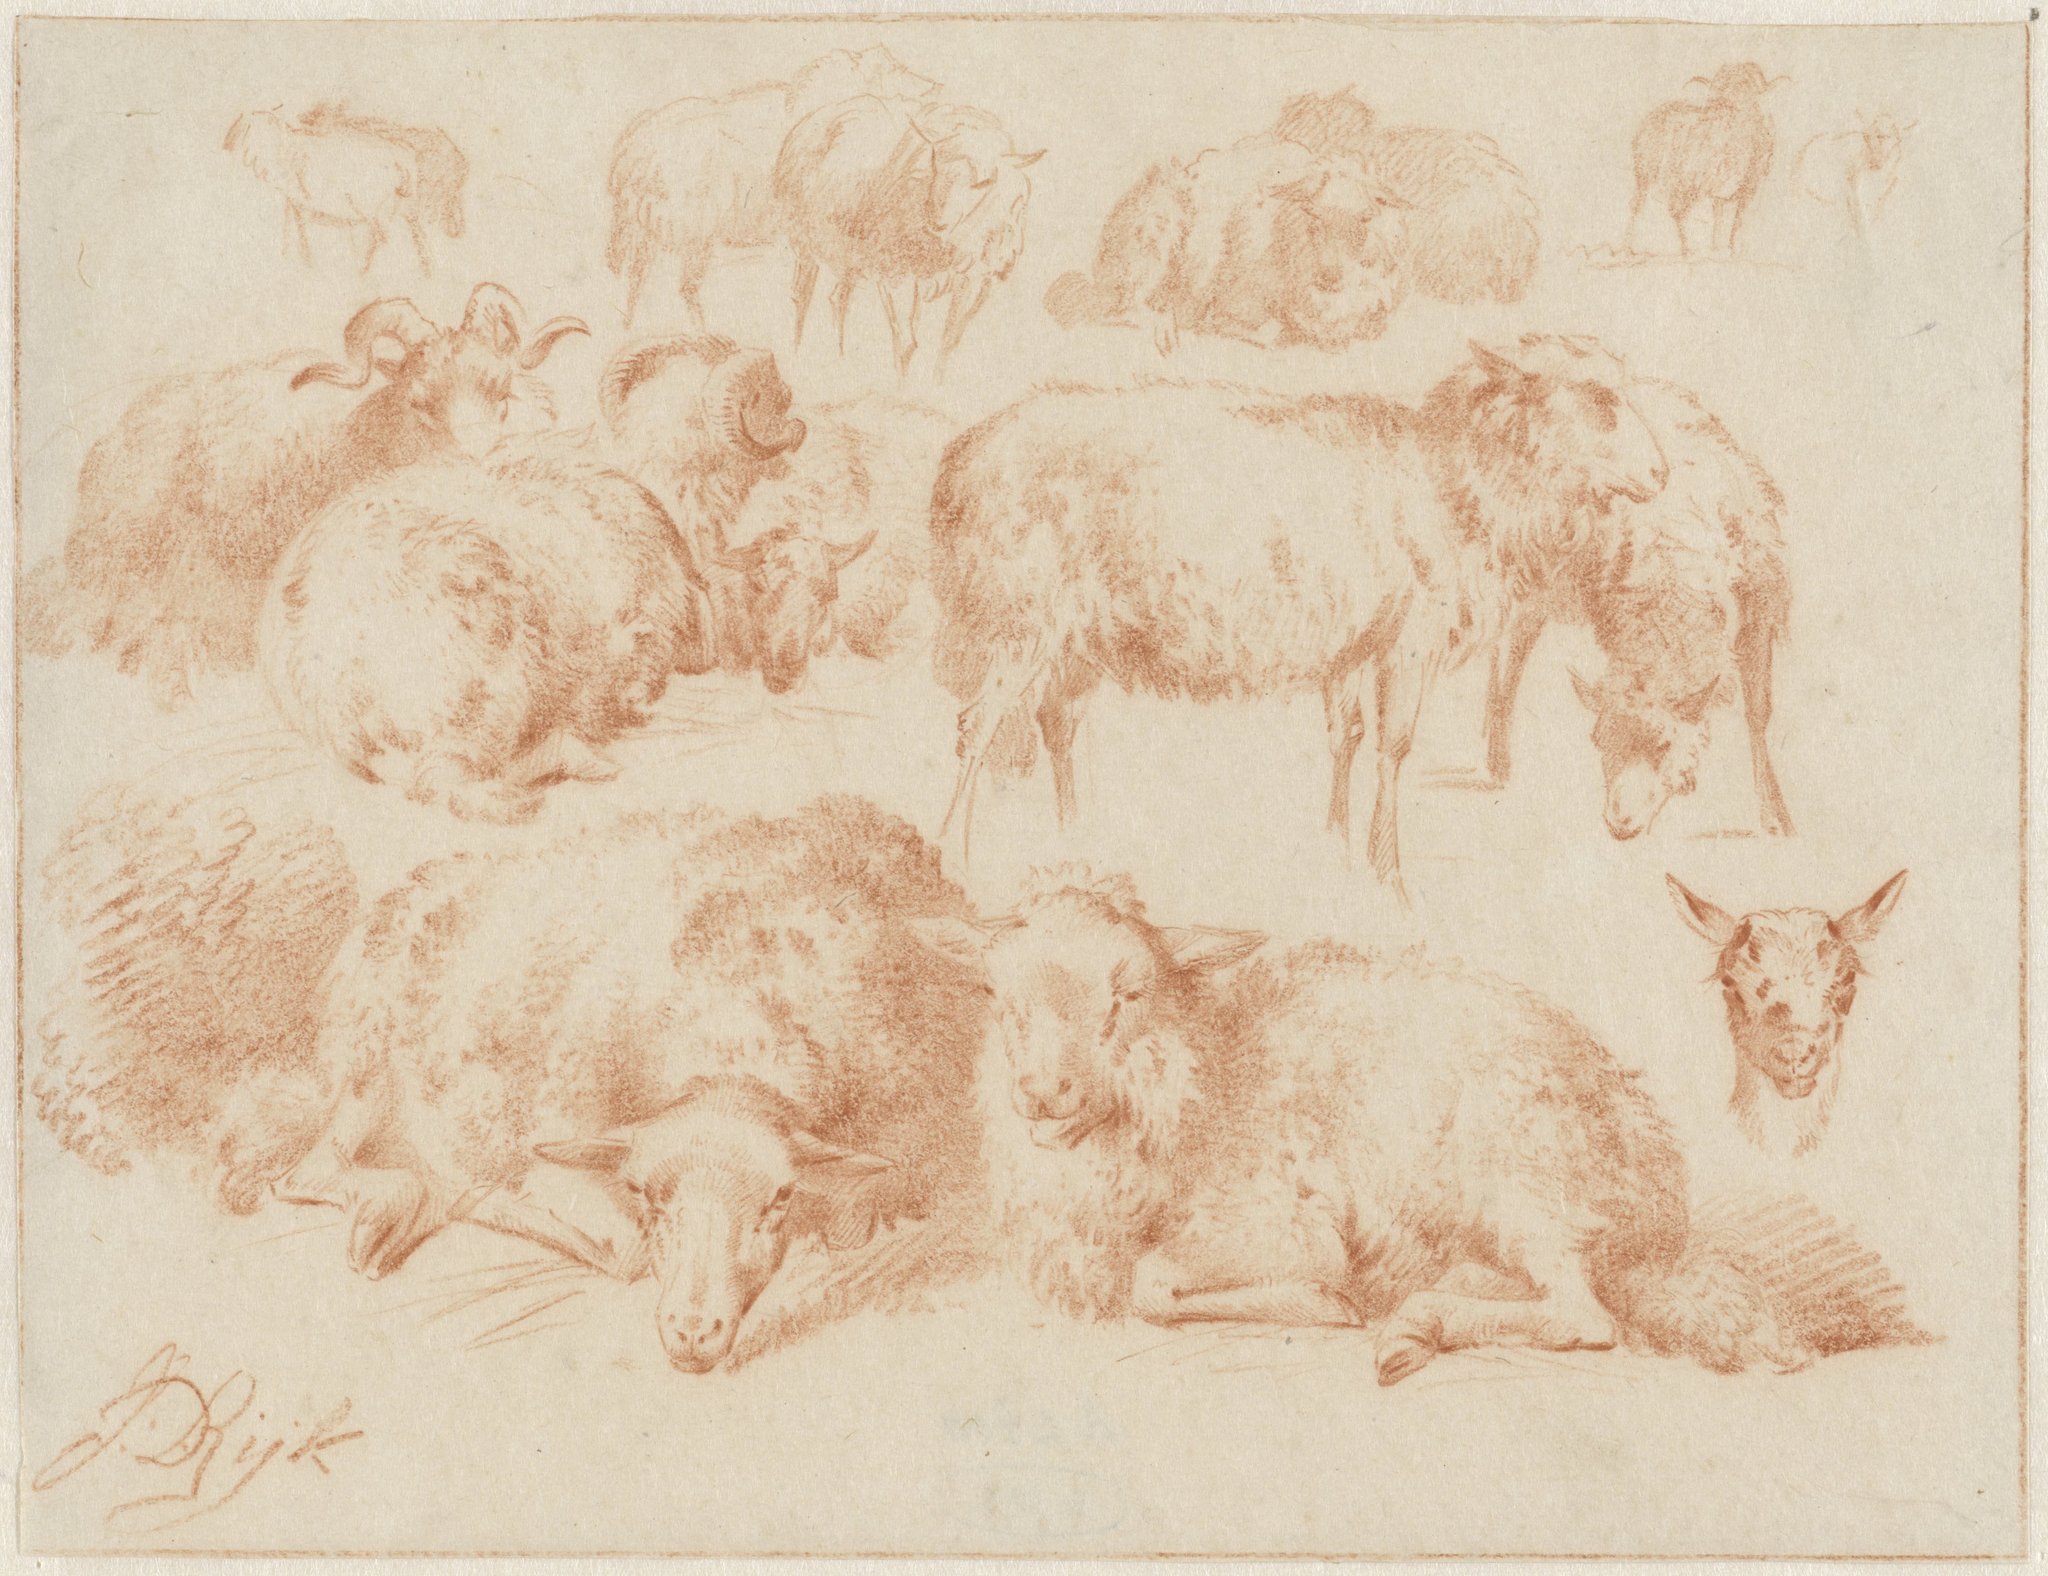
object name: drawing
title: Studies van schapen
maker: james de rijk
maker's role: draughtsman, painter, print maker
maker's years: 1806-1882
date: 1816-1882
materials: chalk, paper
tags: sheep